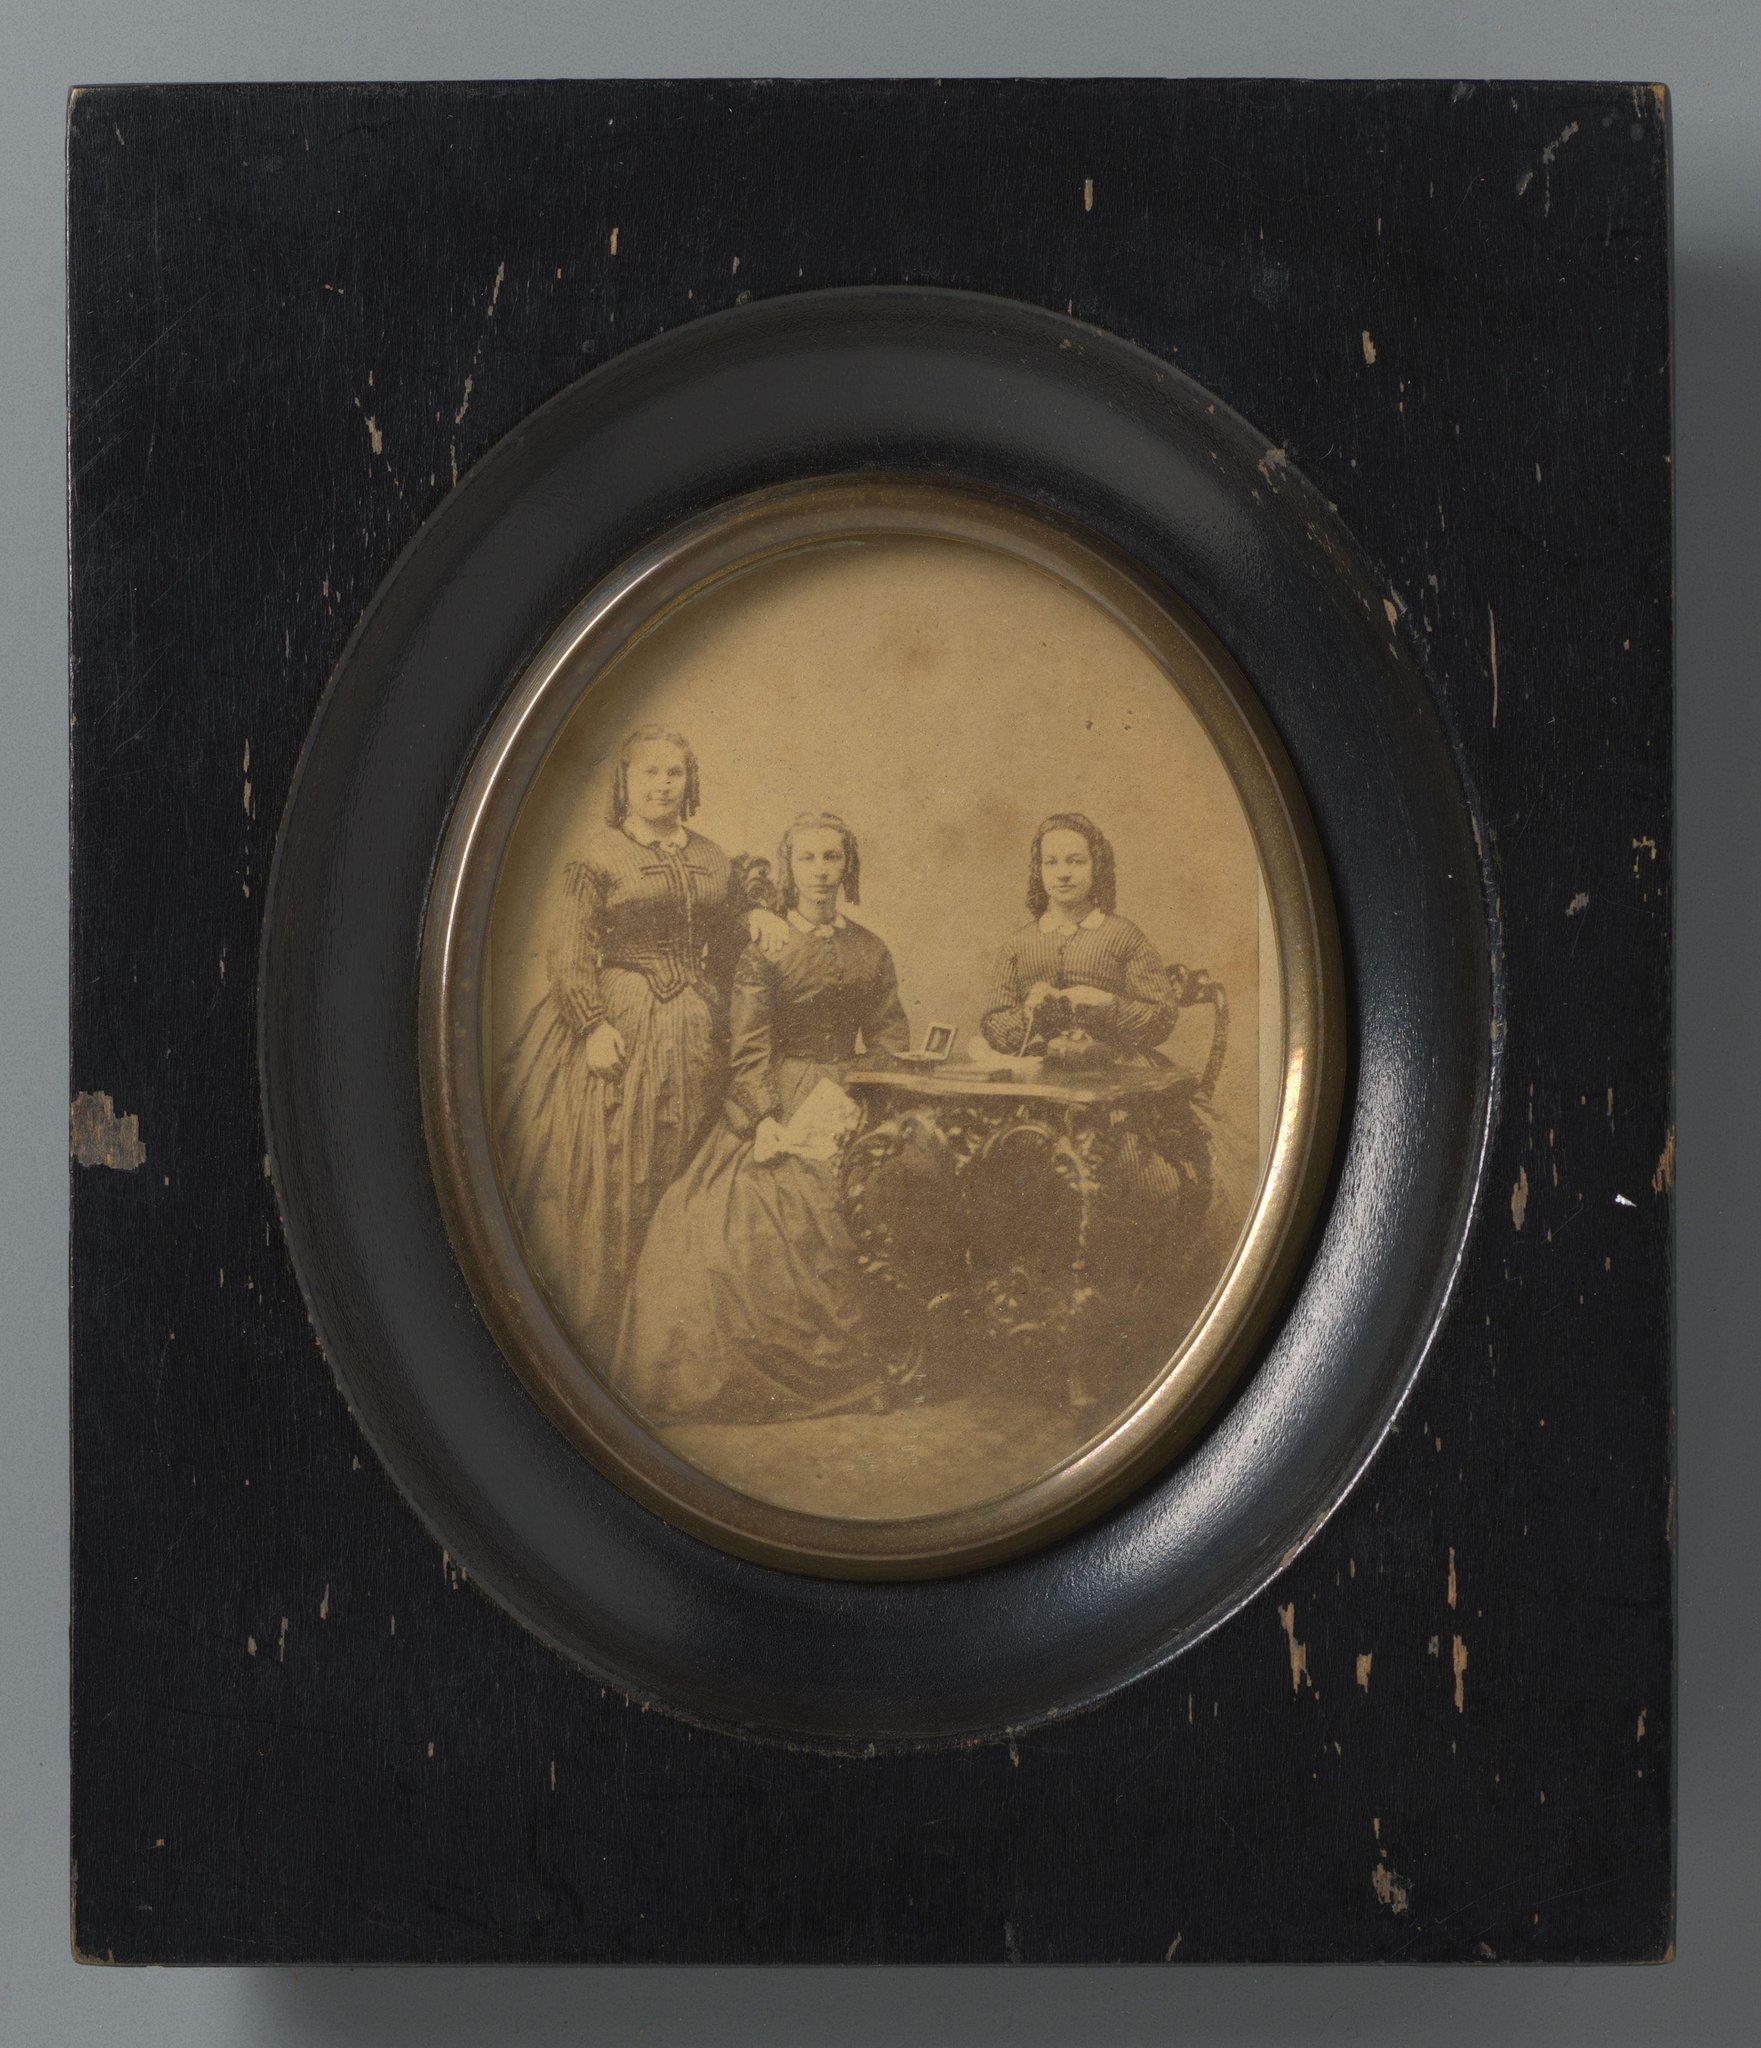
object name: frame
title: Groepsportret van drie onbekende vrouwen rond een tafel, met daarop foto's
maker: Anonymous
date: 1855-1860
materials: cardboard, glass, leather, metal, paper, wood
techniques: albumen print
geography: roermond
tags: historical persons not known by name - bb - woman, anonymous historical persons portrayed in a group, in a group-portrait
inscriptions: label: ‘Firma Gerard Pisters/ (H. Grevers)/ Steenweg 4/ Roermond’